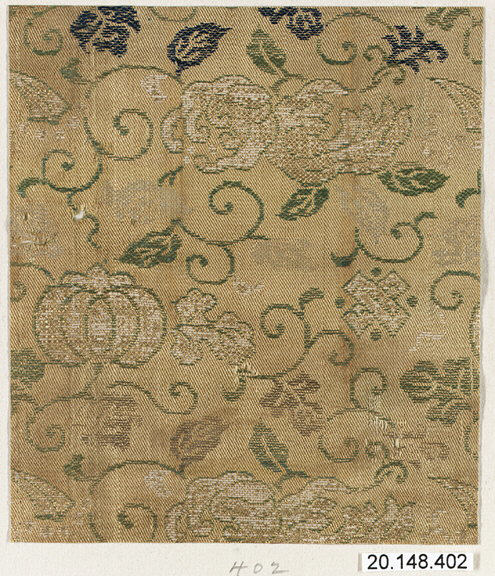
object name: piece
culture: japanese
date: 1601-1700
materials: silk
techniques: compound weave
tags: flowers,leaves